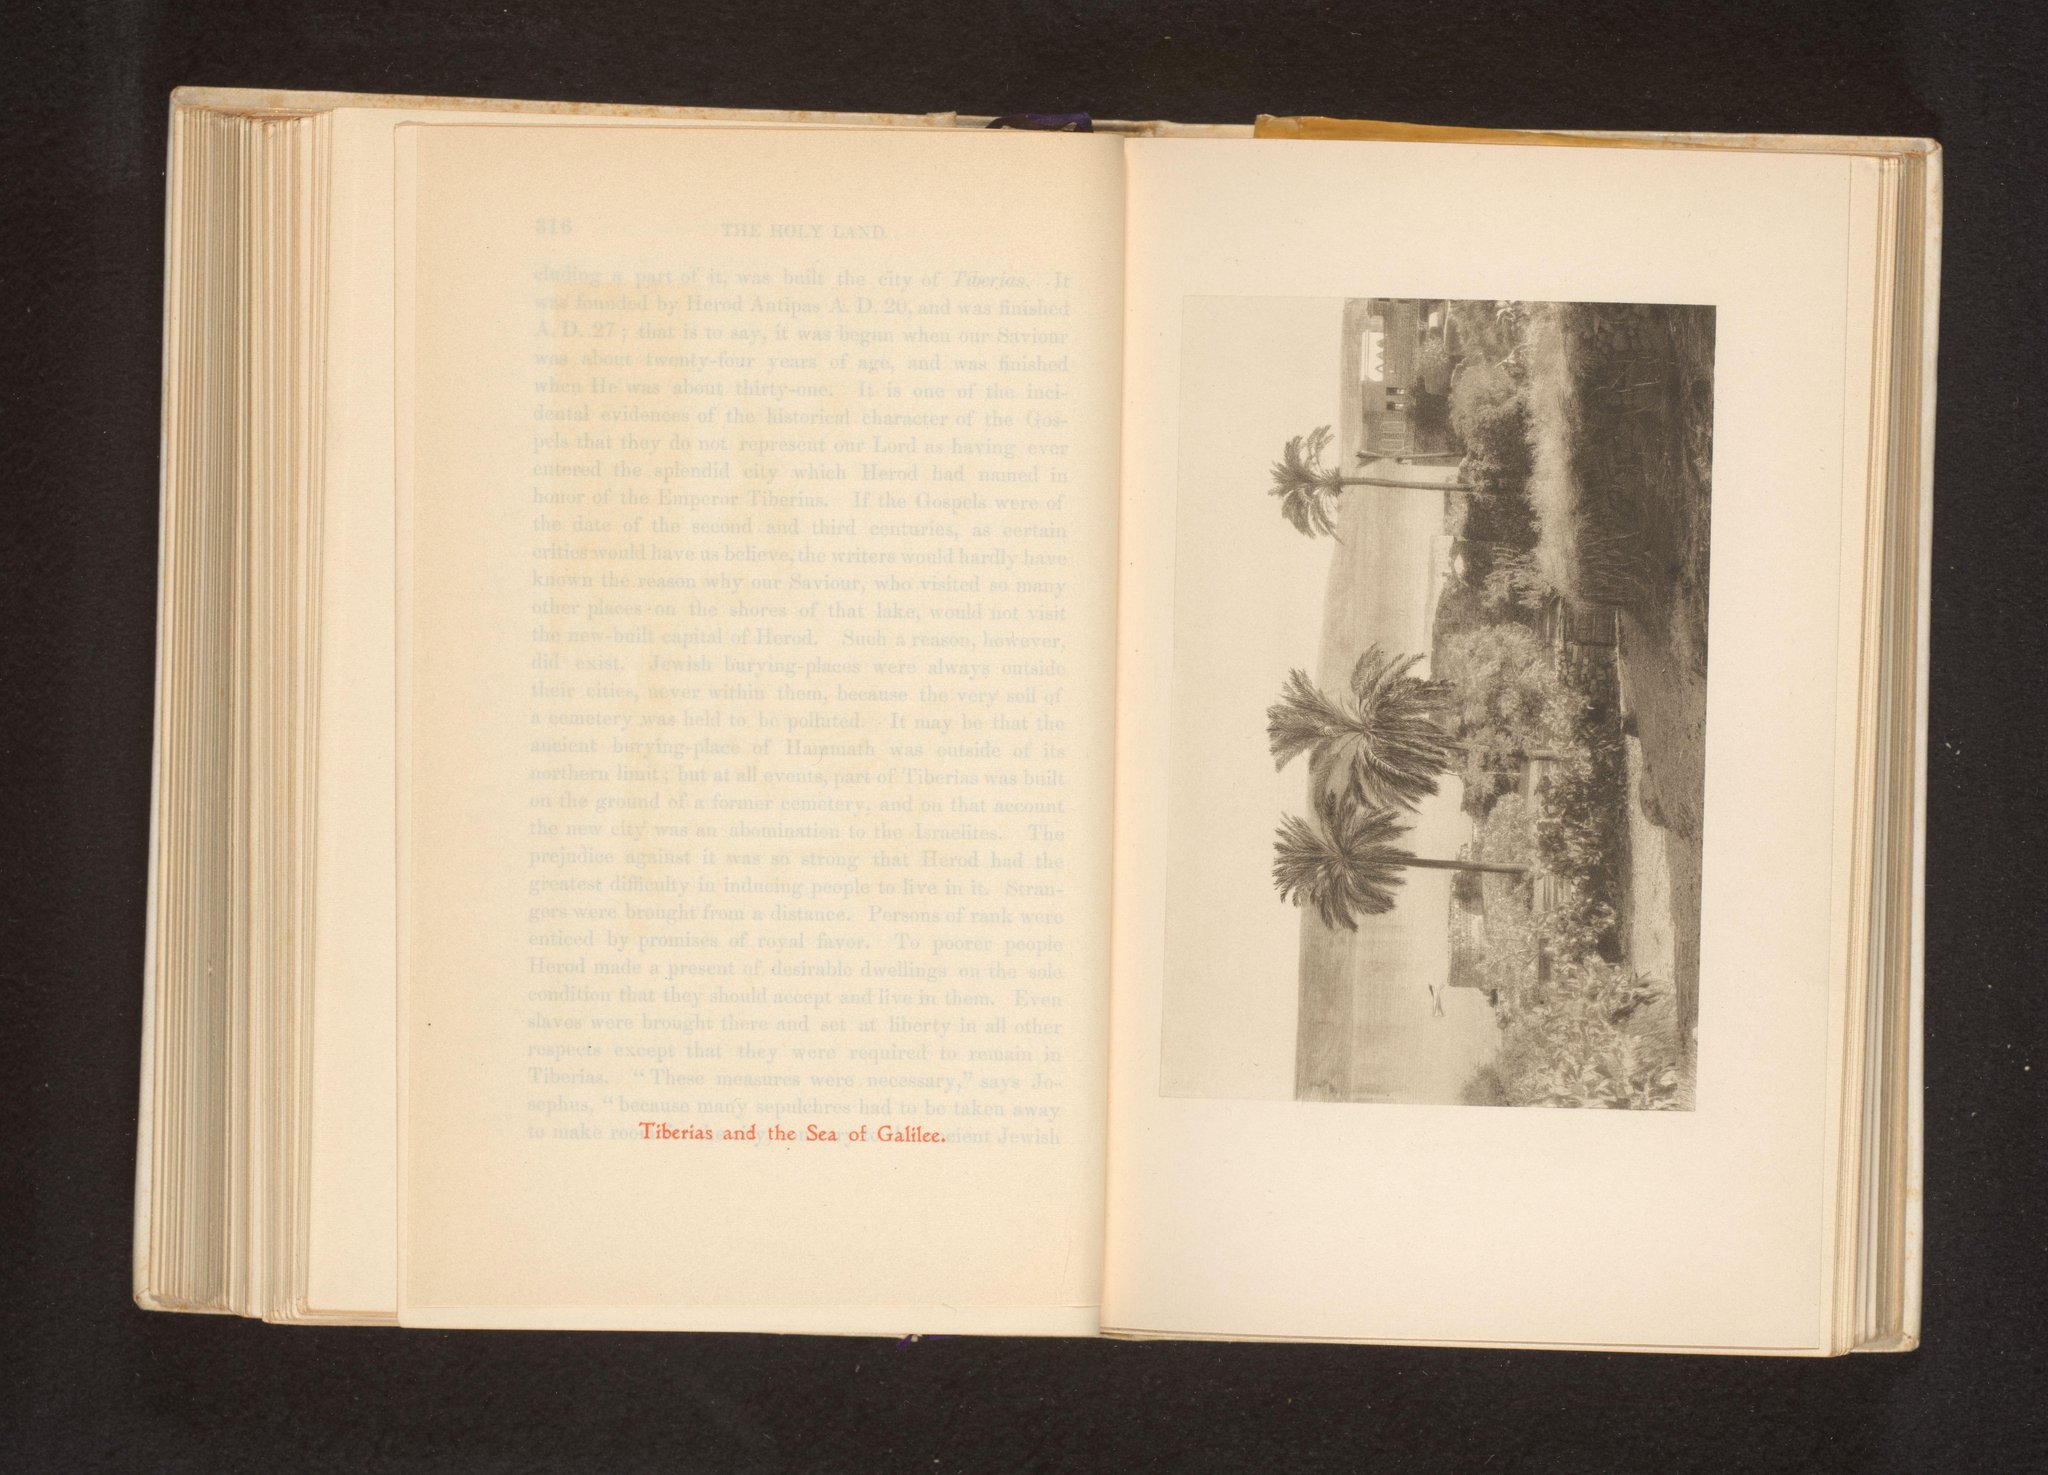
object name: photomechanical print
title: Gezicht op Tiberias en het Meer van Tiberias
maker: Anonymous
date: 1890-1900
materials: paper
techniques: photoaquatint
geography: tiberias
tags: city-view in general; 'veduta', lake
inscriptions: title: ‘Tiberias and the Sea of Galilee.’